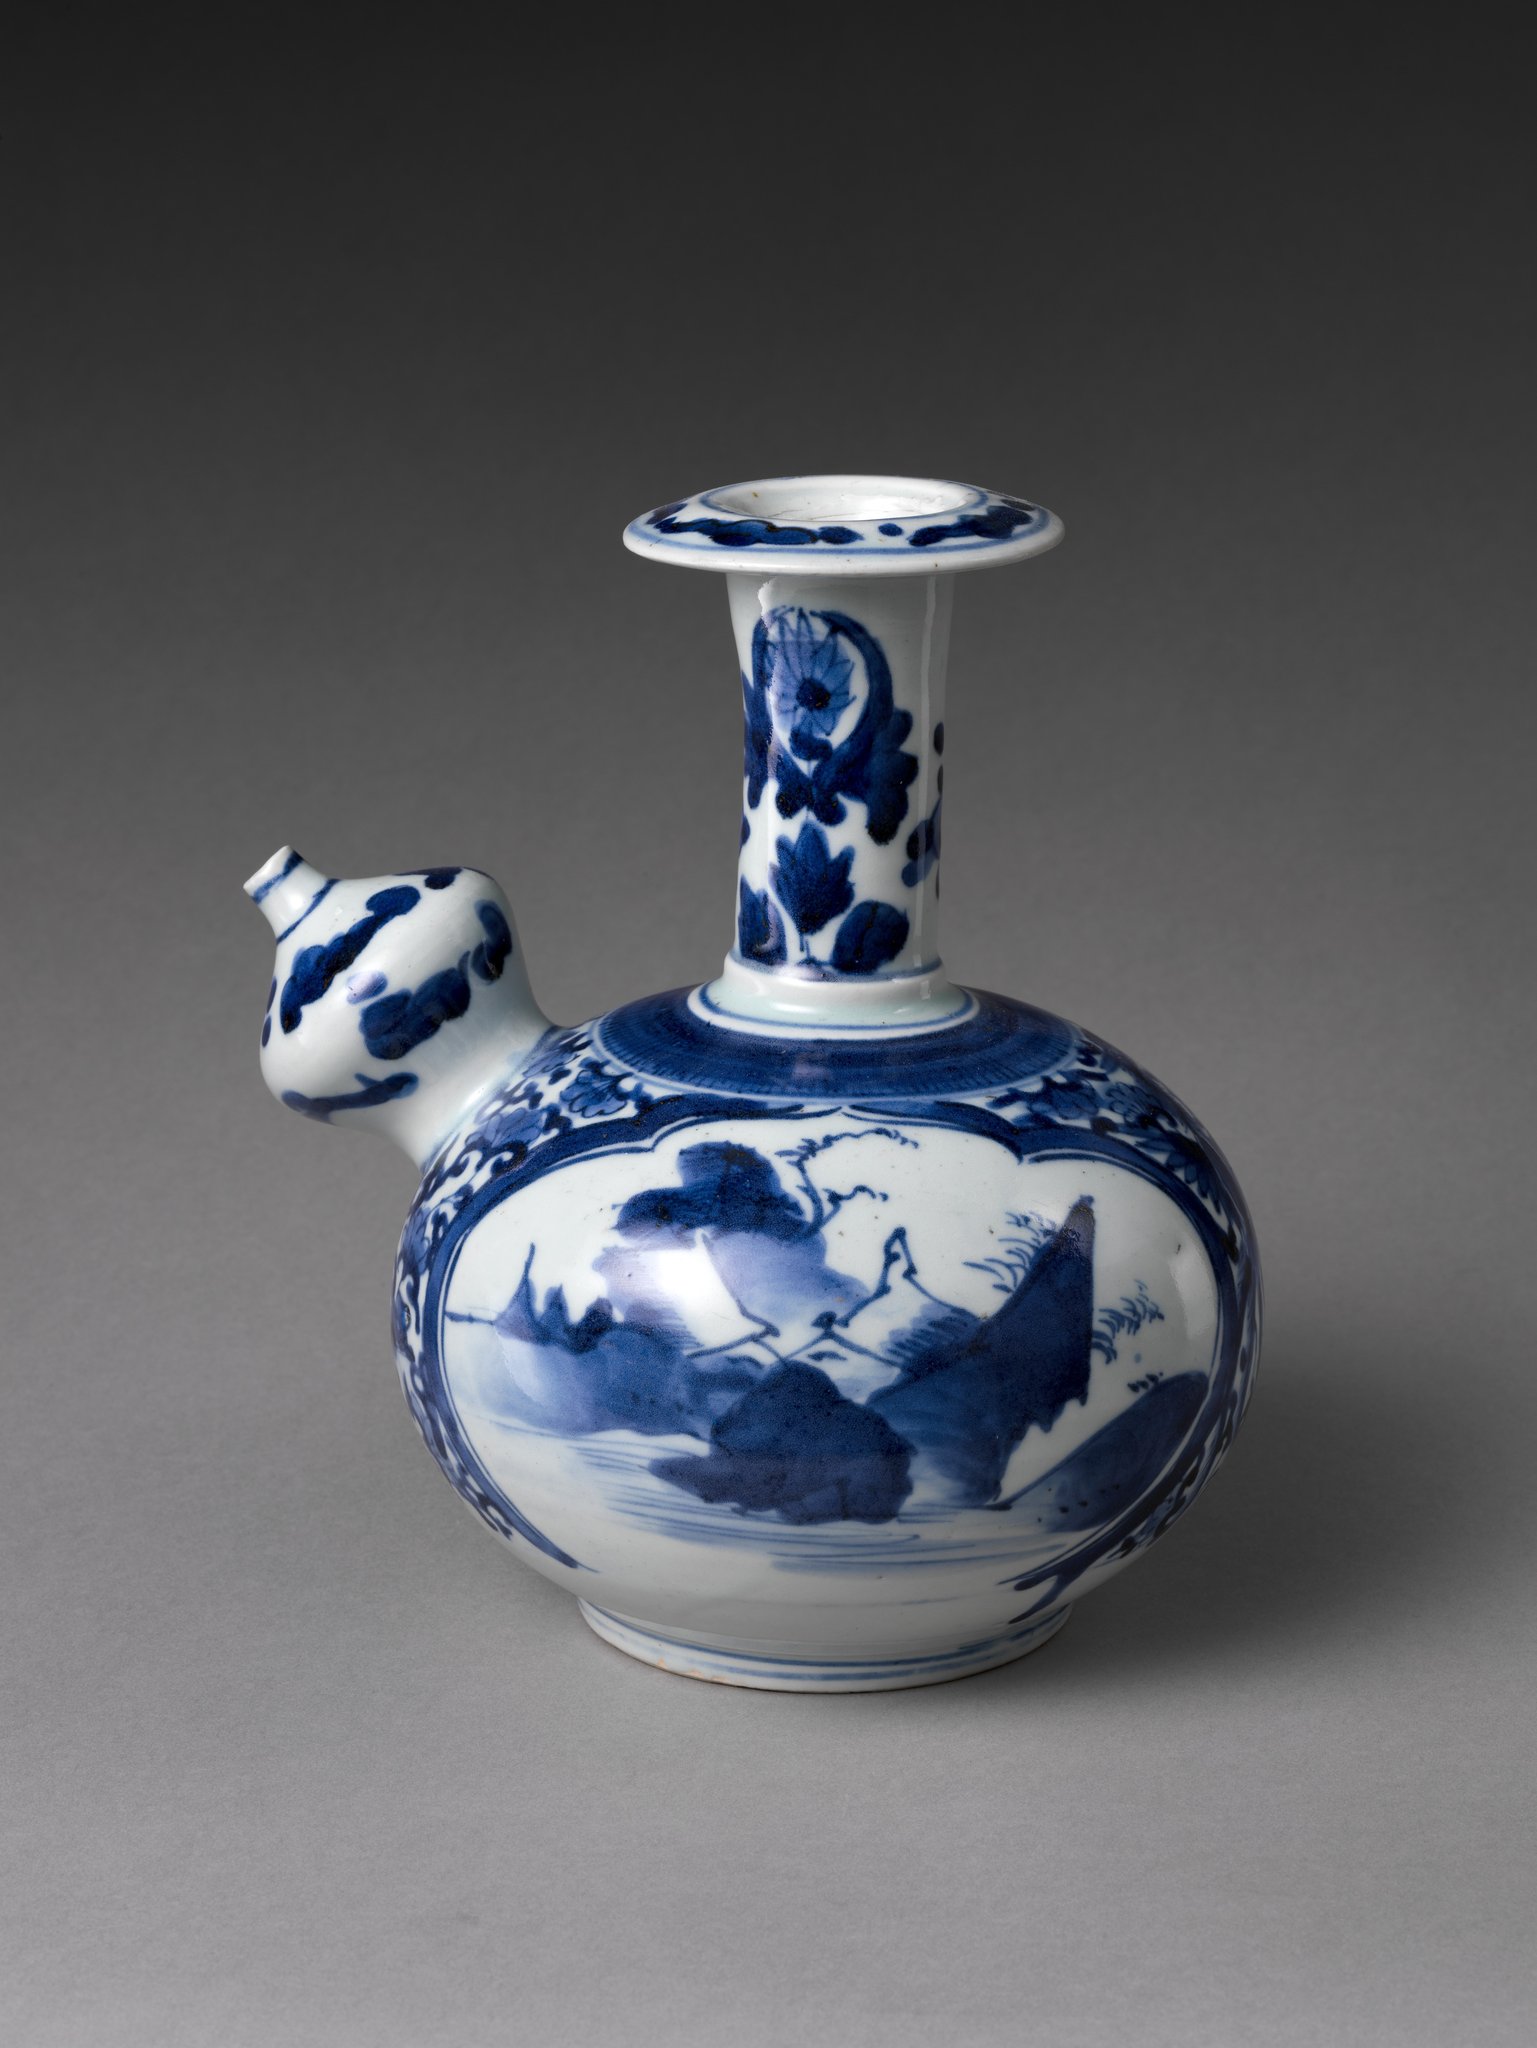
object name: pouring vessel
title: Pouring vessel (kendi) with landscape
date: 1660-1680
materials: cobalt, glaze, hard paste porcelain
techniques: painting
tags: flowers,landscapes